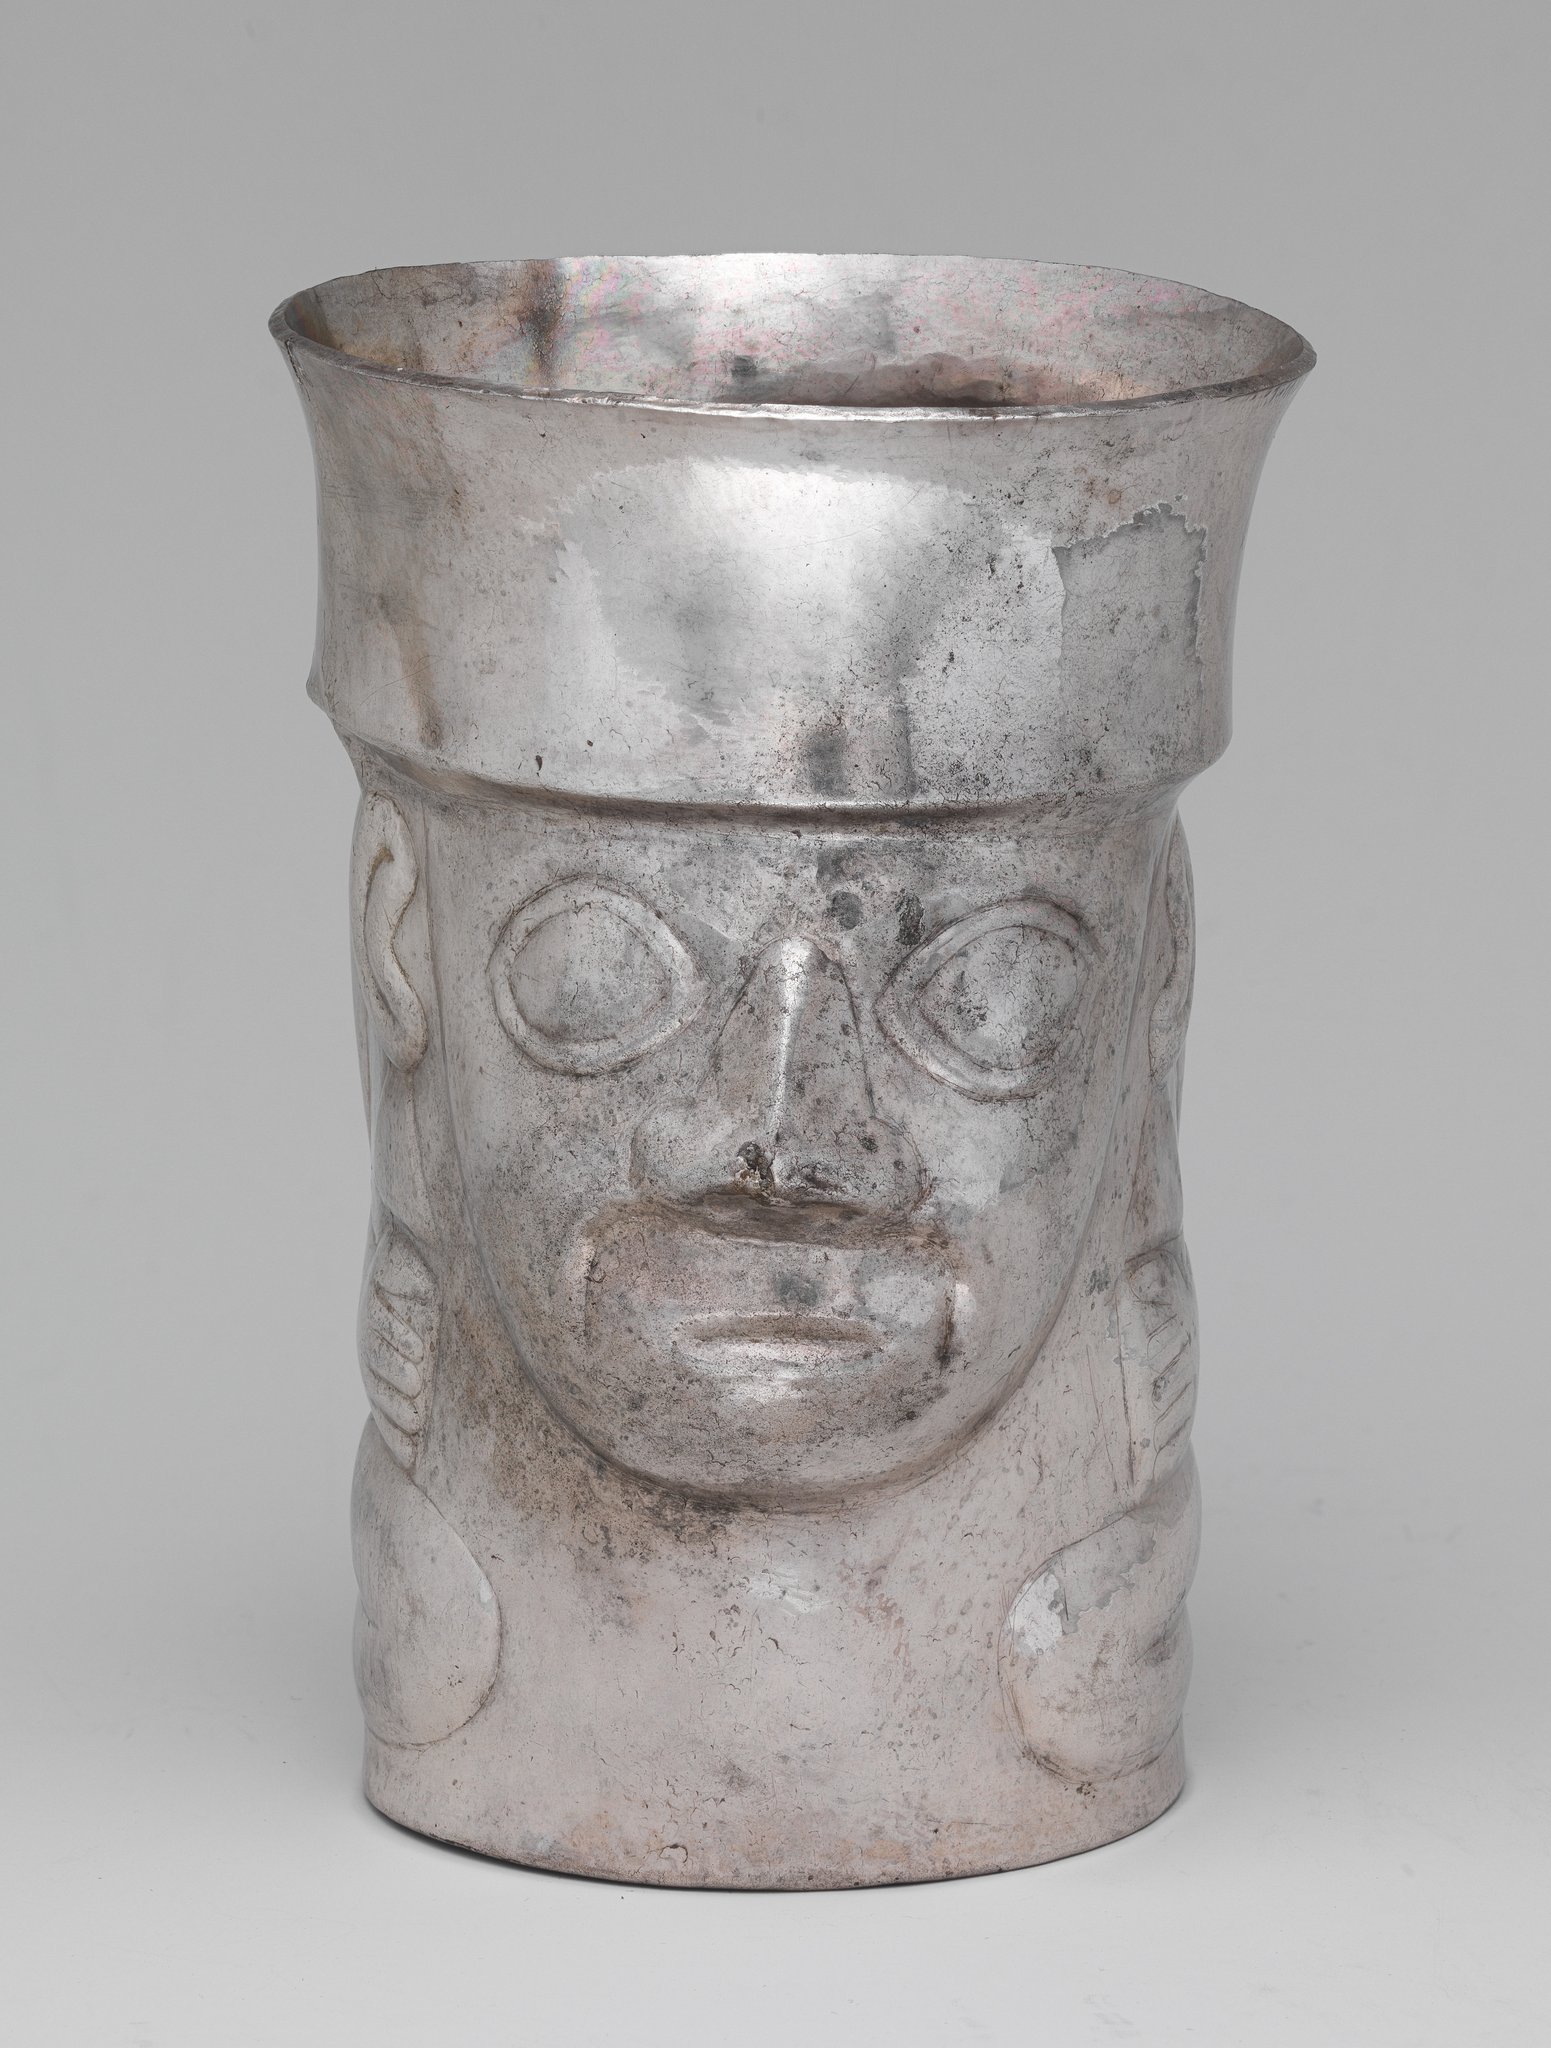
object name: beaker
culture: chimú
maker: chimú artist(s)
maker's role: artist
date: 1100-1470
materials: silver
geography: peru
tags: faces